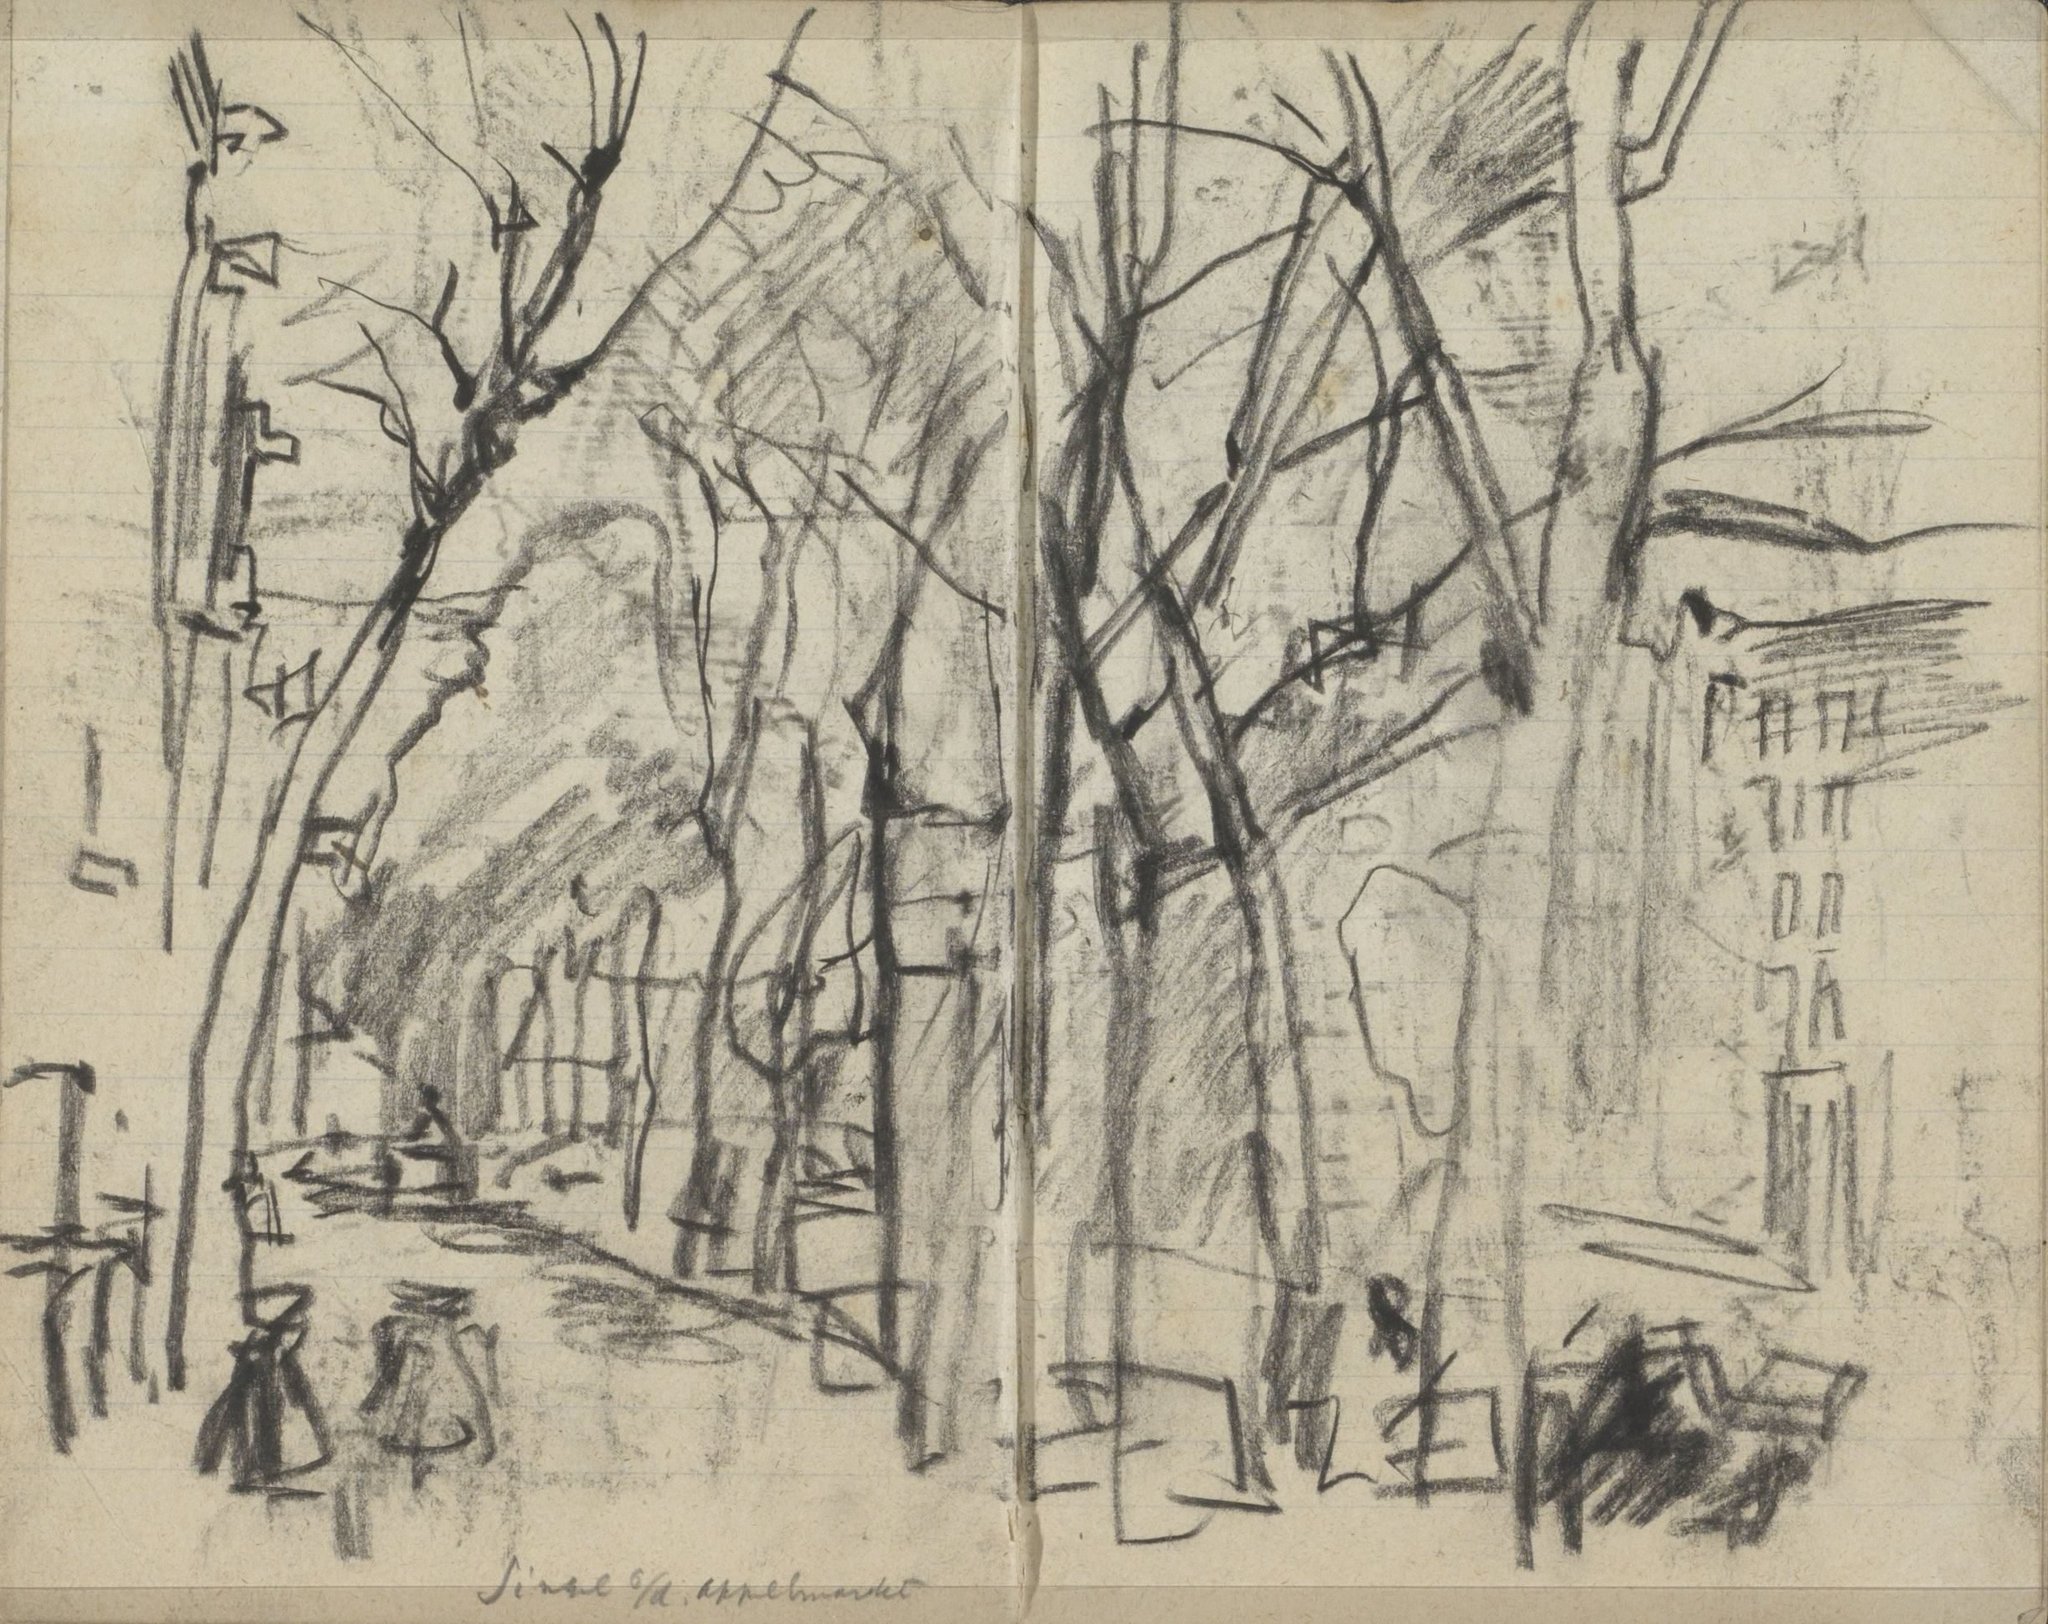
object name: sketchbook leaf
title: Gezicht op het Singel in Amsterdam ter hoogte van de Appelmarkt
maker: george hendrik breitner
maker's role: draughtsman, painter, print maker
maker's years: 1857-1923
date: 1893-1898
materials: chalk, paper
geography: amsterdam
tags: civic architecture; edifices; dwellings, canals, waters (in city) (+ city(-scape) with figures, staffage)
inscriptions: annotation: ‘Singel b/d Appelmarkt’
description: Pagina 37 en pagina 38 uit een schetsboek met 31 bladen.